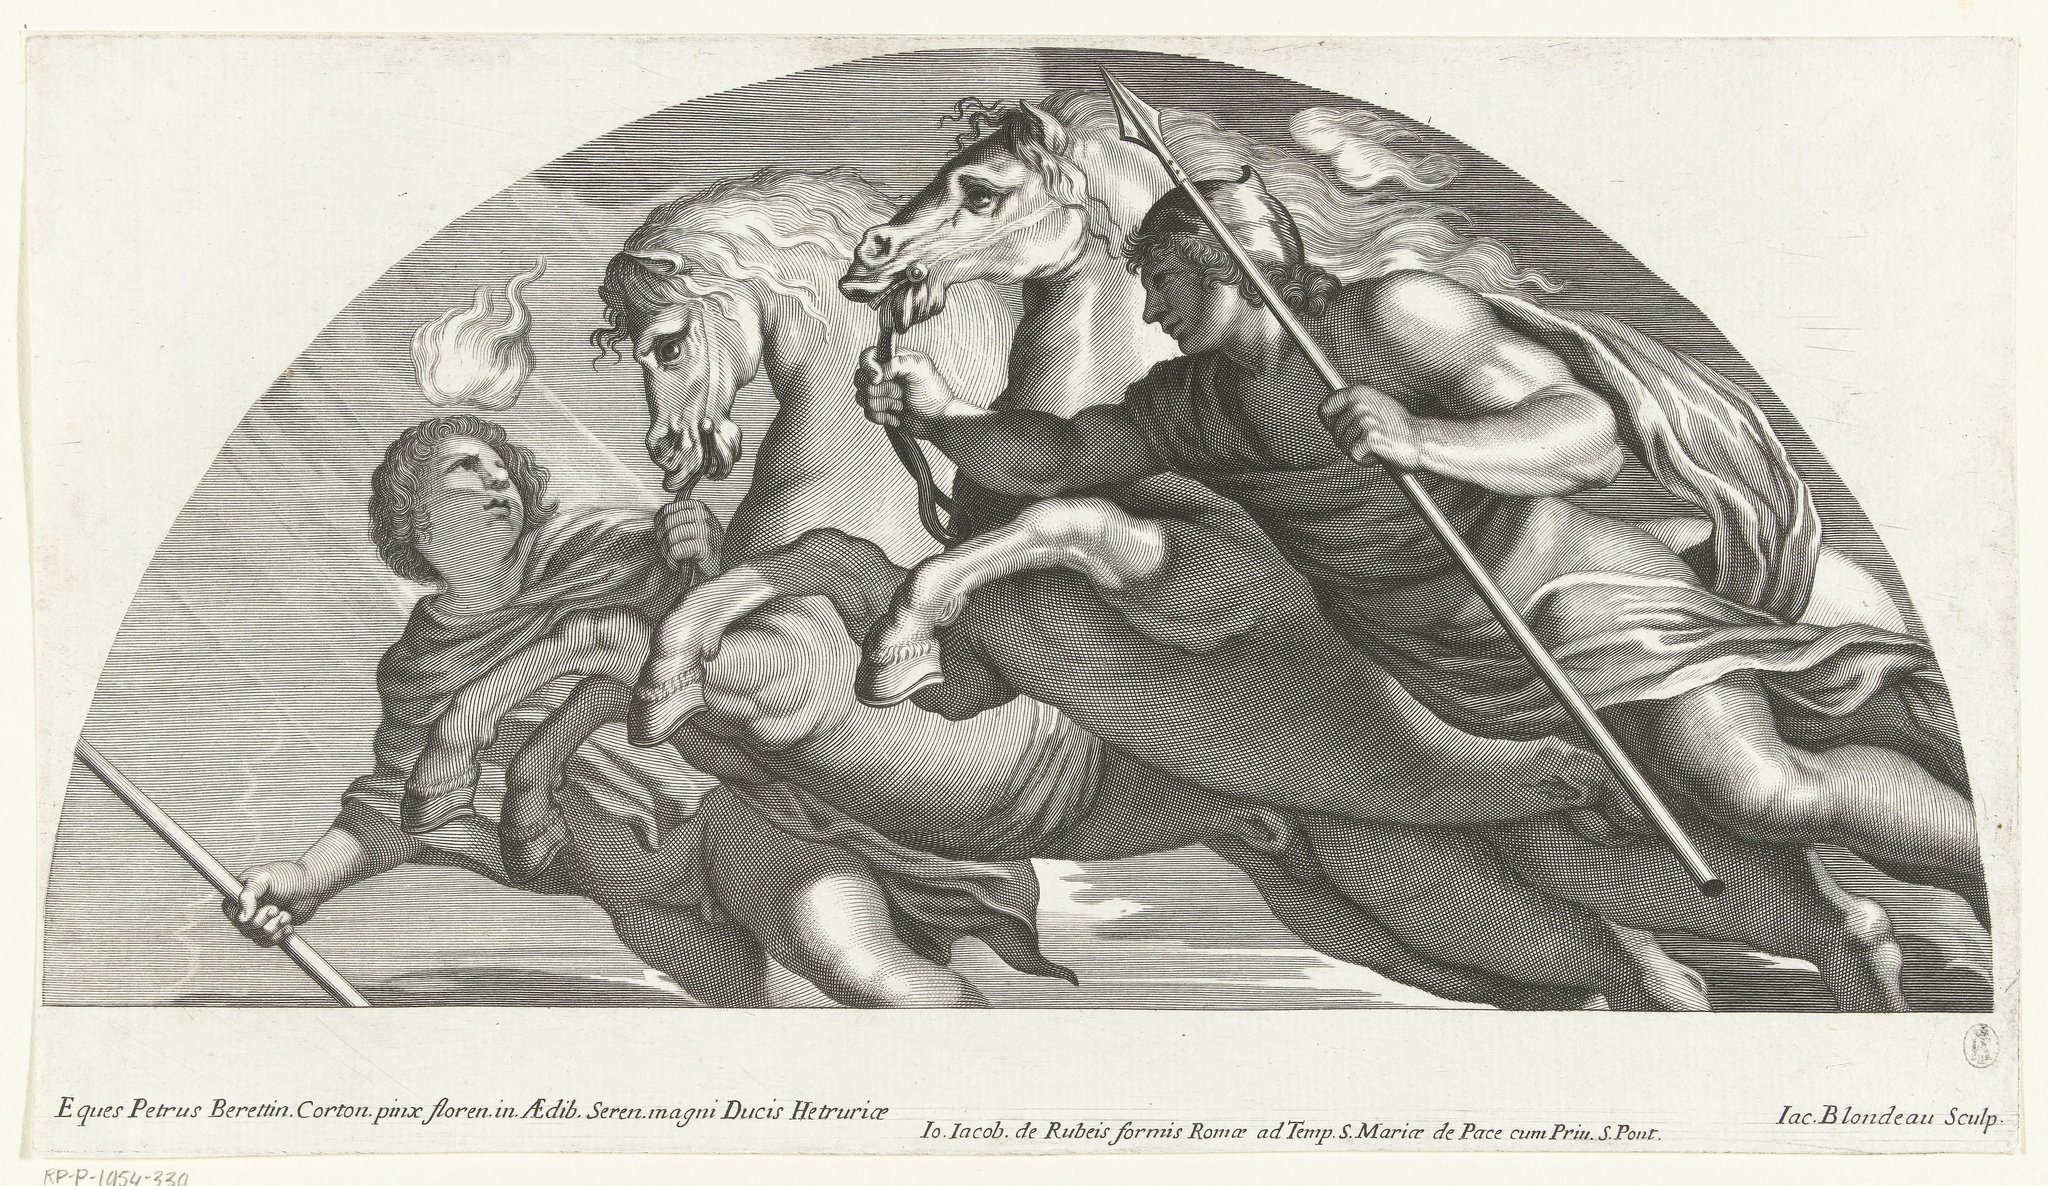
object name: print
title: Twee genii met twee paarden aan leidsel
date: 1665-1698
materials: paper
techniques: engraving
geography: rome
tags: genii (roman tutelary spirits); 'genio' (ripa)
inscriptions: collector's mark: Lugt 2228, collector's mark: Lugt 971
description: Twee genii met twee paarden aan leidsel op halfrond boogveld.